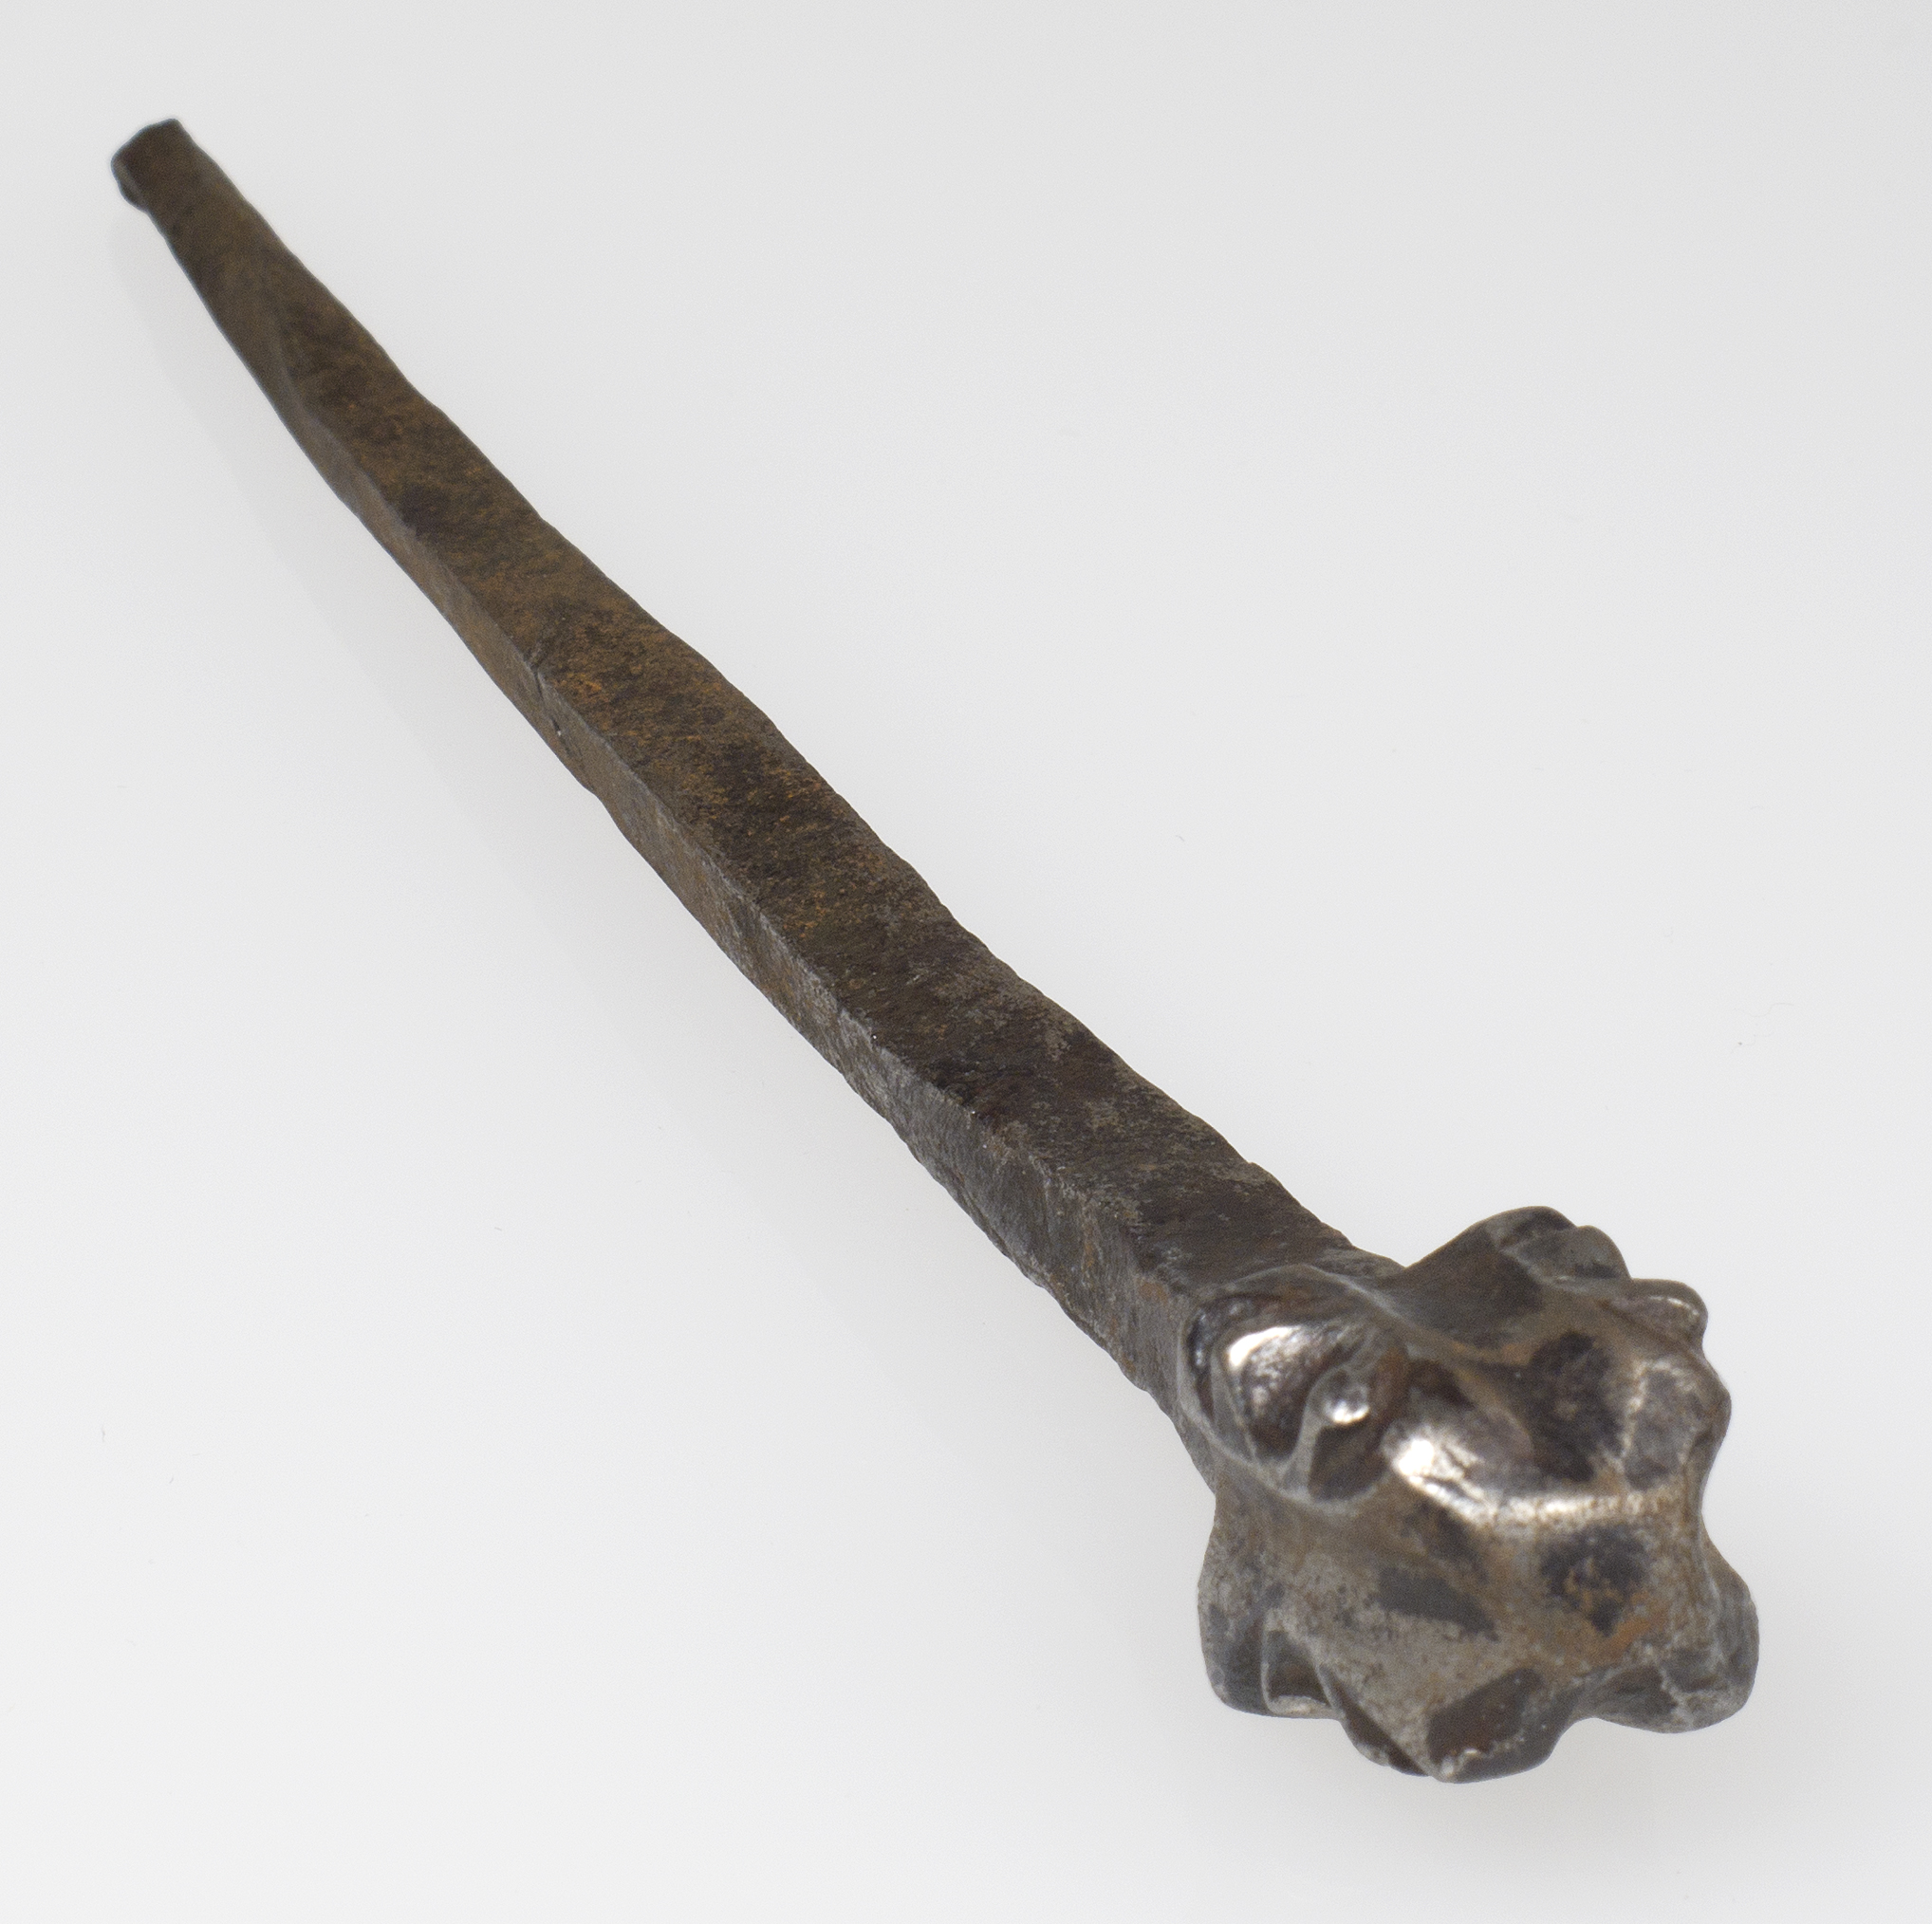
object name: nail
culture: european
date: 1401-1600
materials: iron